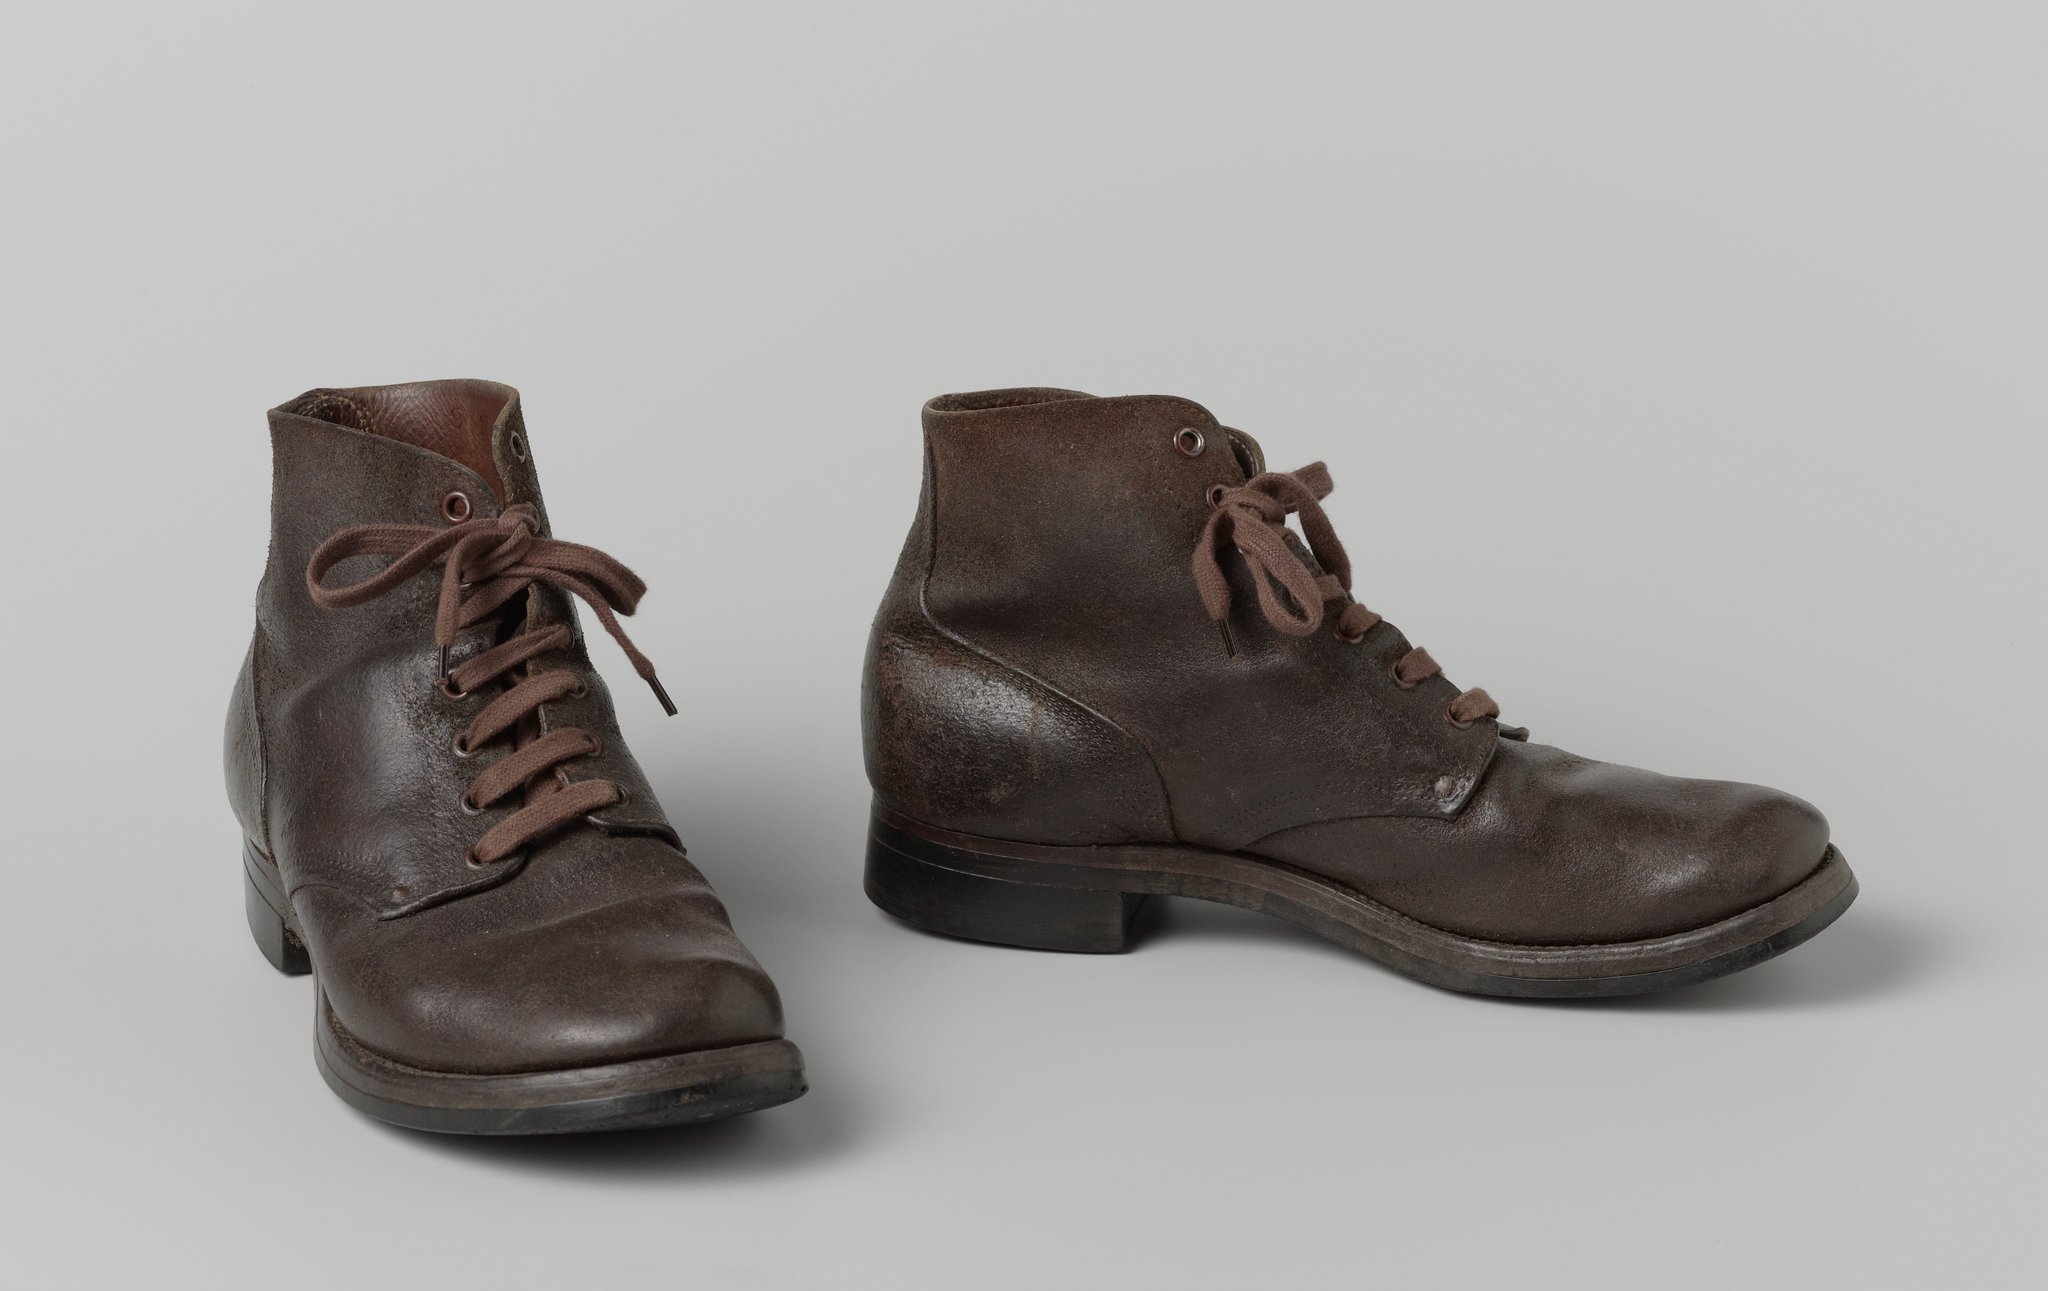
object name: menswear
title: Schoen gedragen door Jhr. Mr. Dr. A.W.L. Tjarda van Starkenborch Stachouwer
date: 1930-1945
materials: iron, leather, rubber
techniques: nailed, stitching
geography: united states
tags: politician, dutch east indies, the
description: Schoen gedragen door Jhr. Mr. Dr. A.W.L. Tjarda van Starkenborch Stachouwer, gekregen na de bevrijding uit een Japans kamp in 1945 van een Amerikaans militair. Zware bruin leren halfhoge schoen, sluitend aan de enkel met leren en daarover rubberen zool met spijkers. Opschrift zool rechts en links: 'WINGFOOT GOODYEAR'. Links: 'Beebe Bros'. Binnenin: 'E'. Bruine veters.